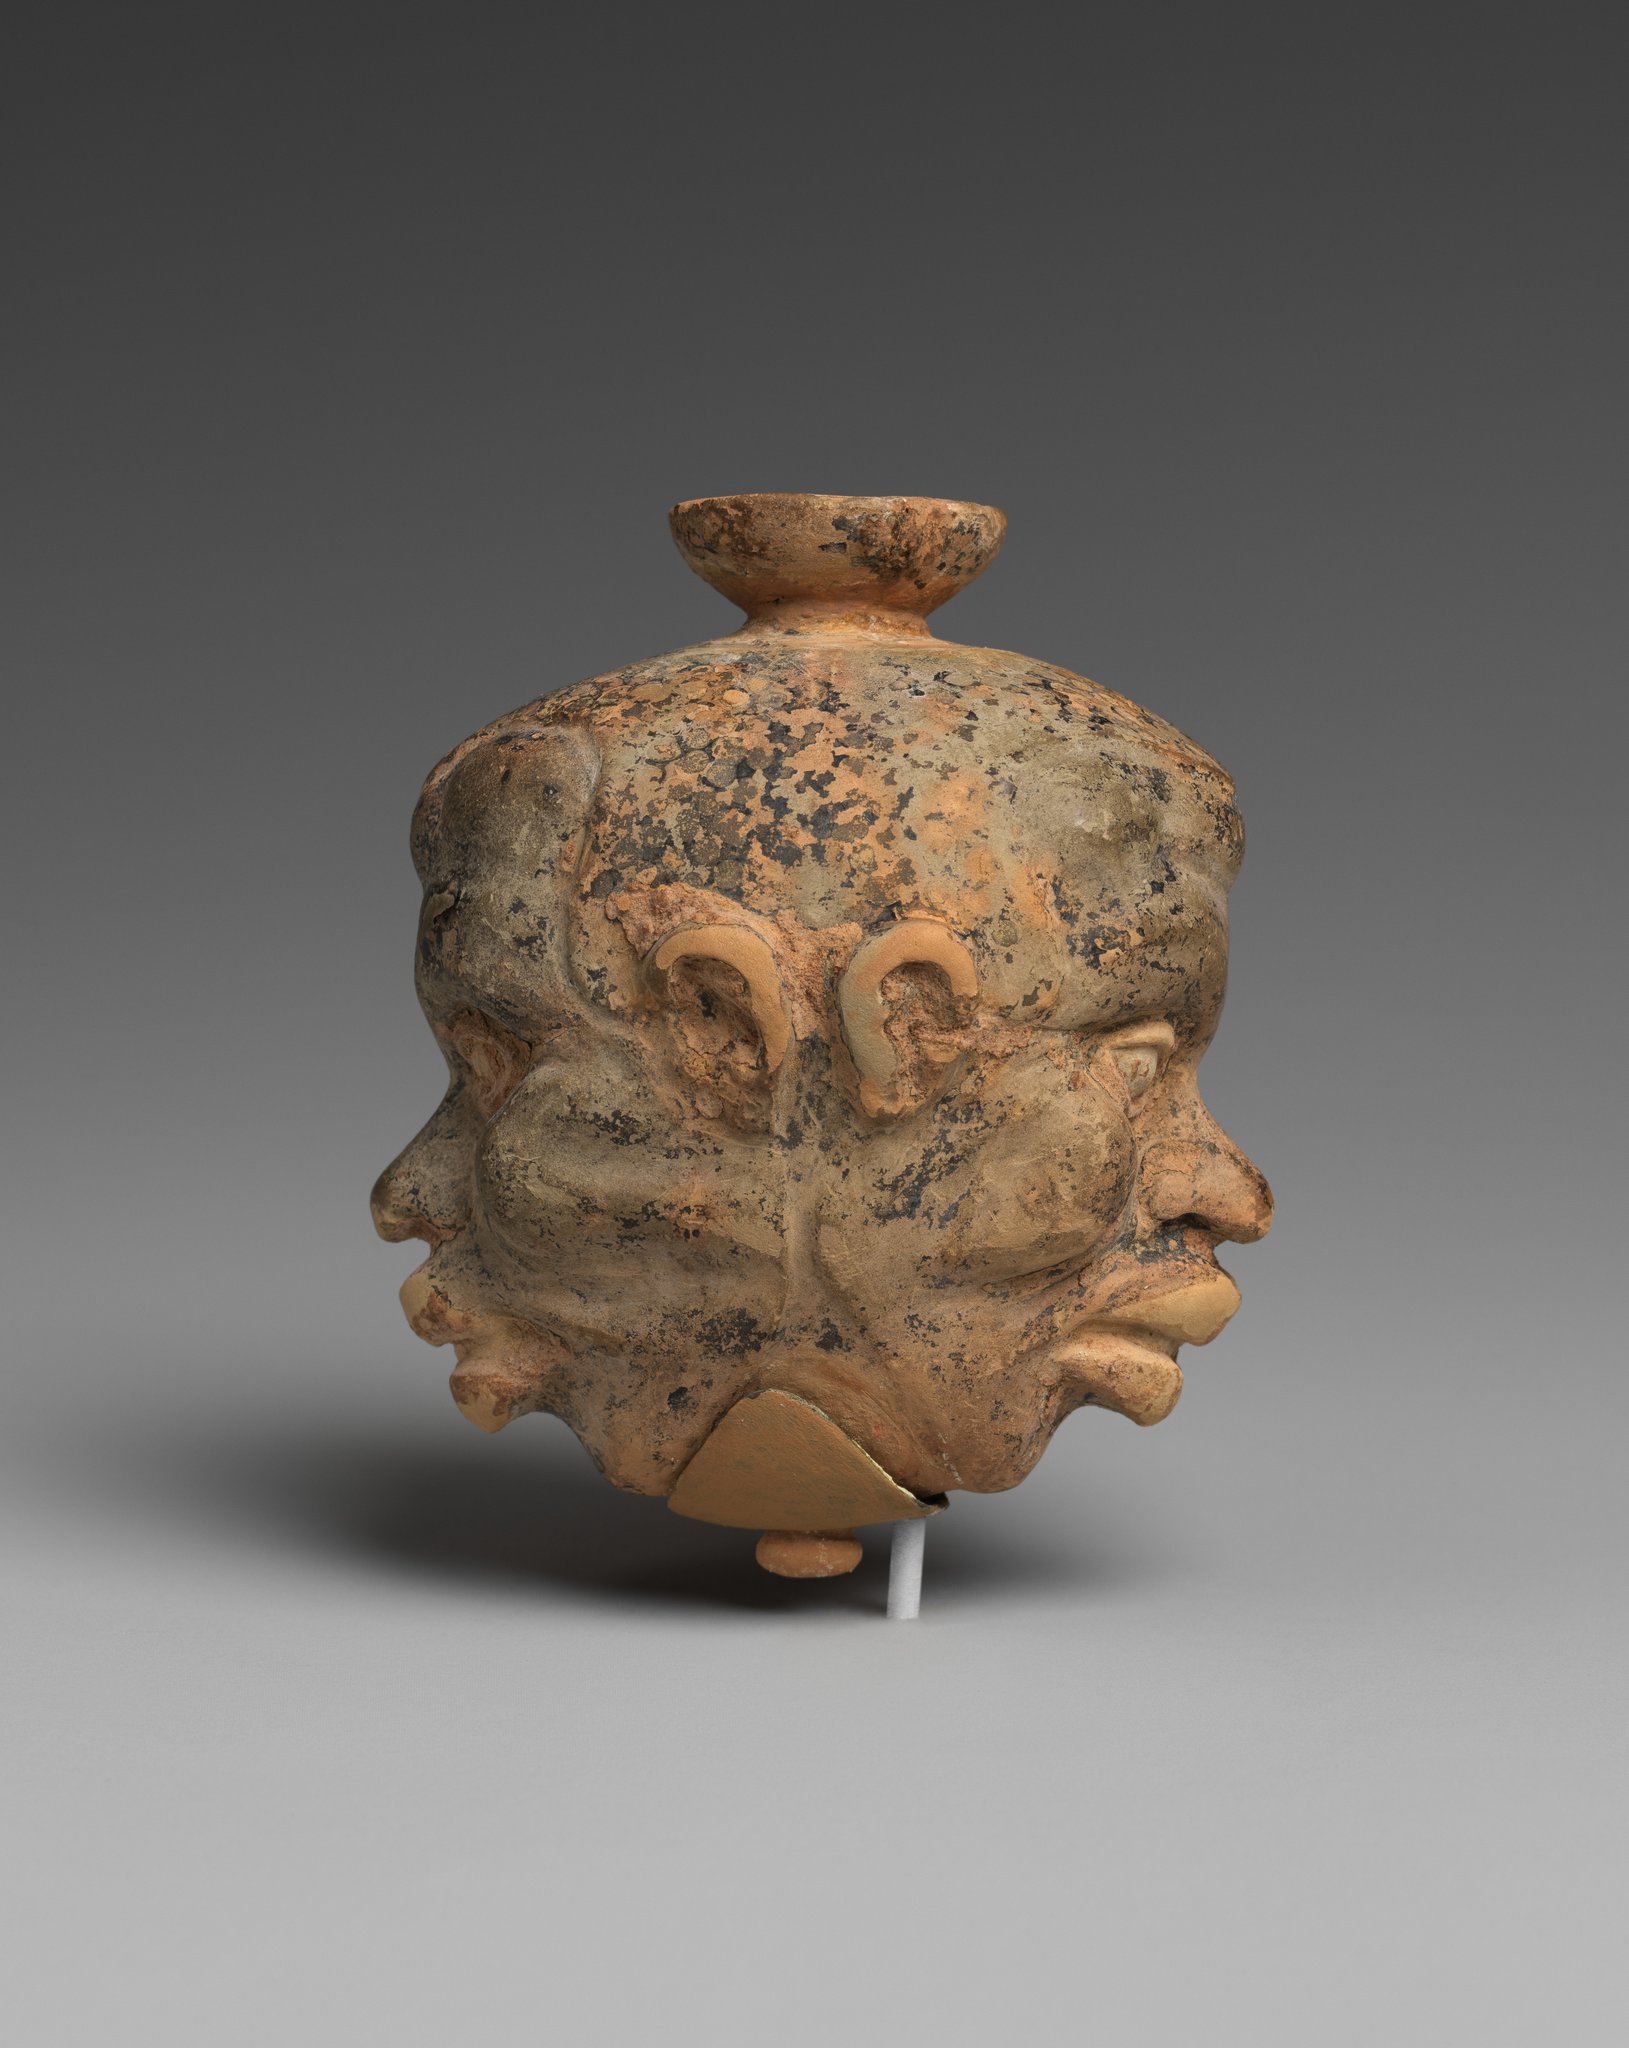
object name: terracotta aryballos oil flask in the form of two black african head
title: Terracotta aryballos (oil flask) in the form of two Black African heads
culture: greek, attic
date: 434-401 BCE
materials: terracotta